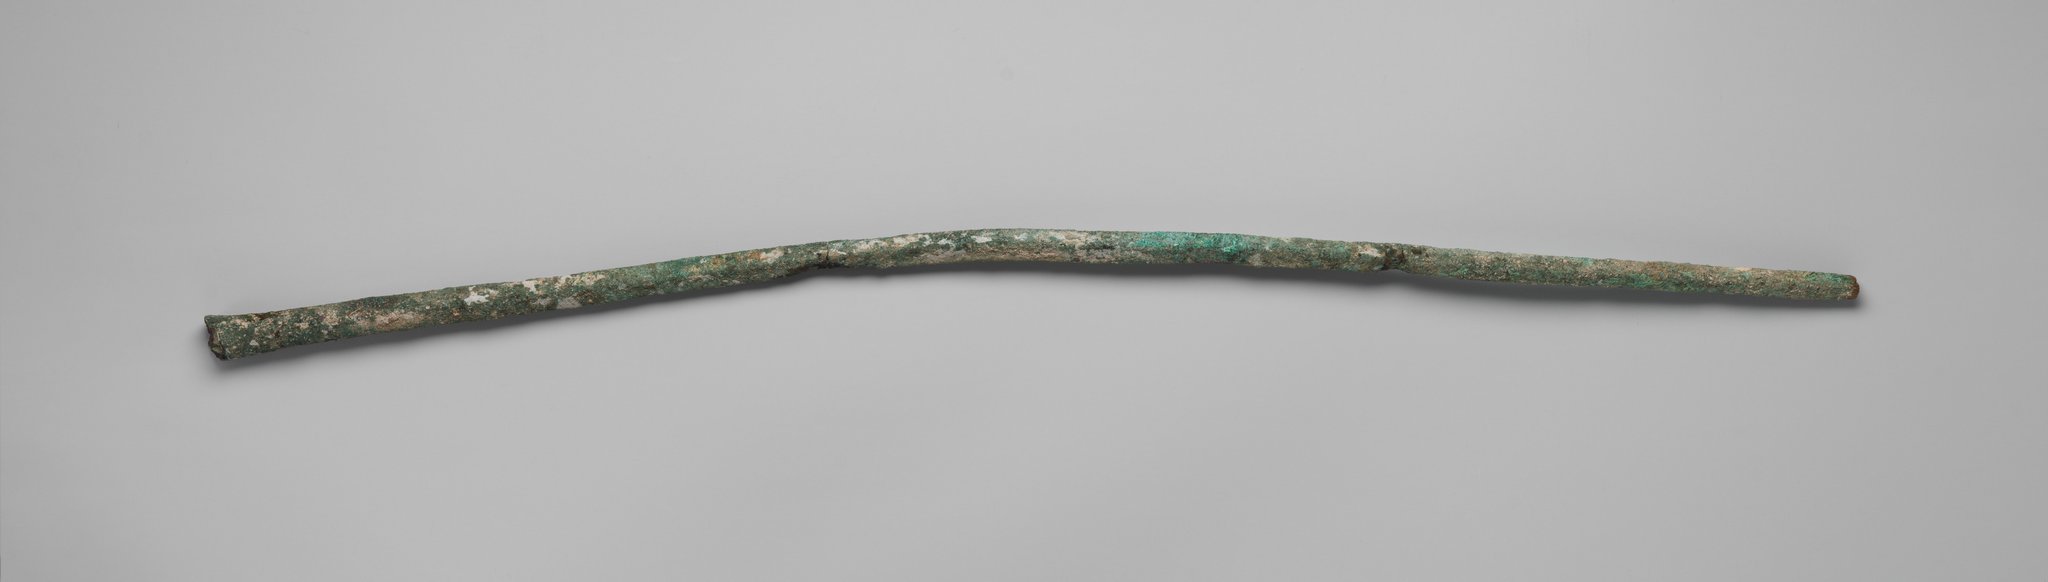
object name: spearhead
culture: cypriot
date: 3900 BCE-100 CE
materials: bronze